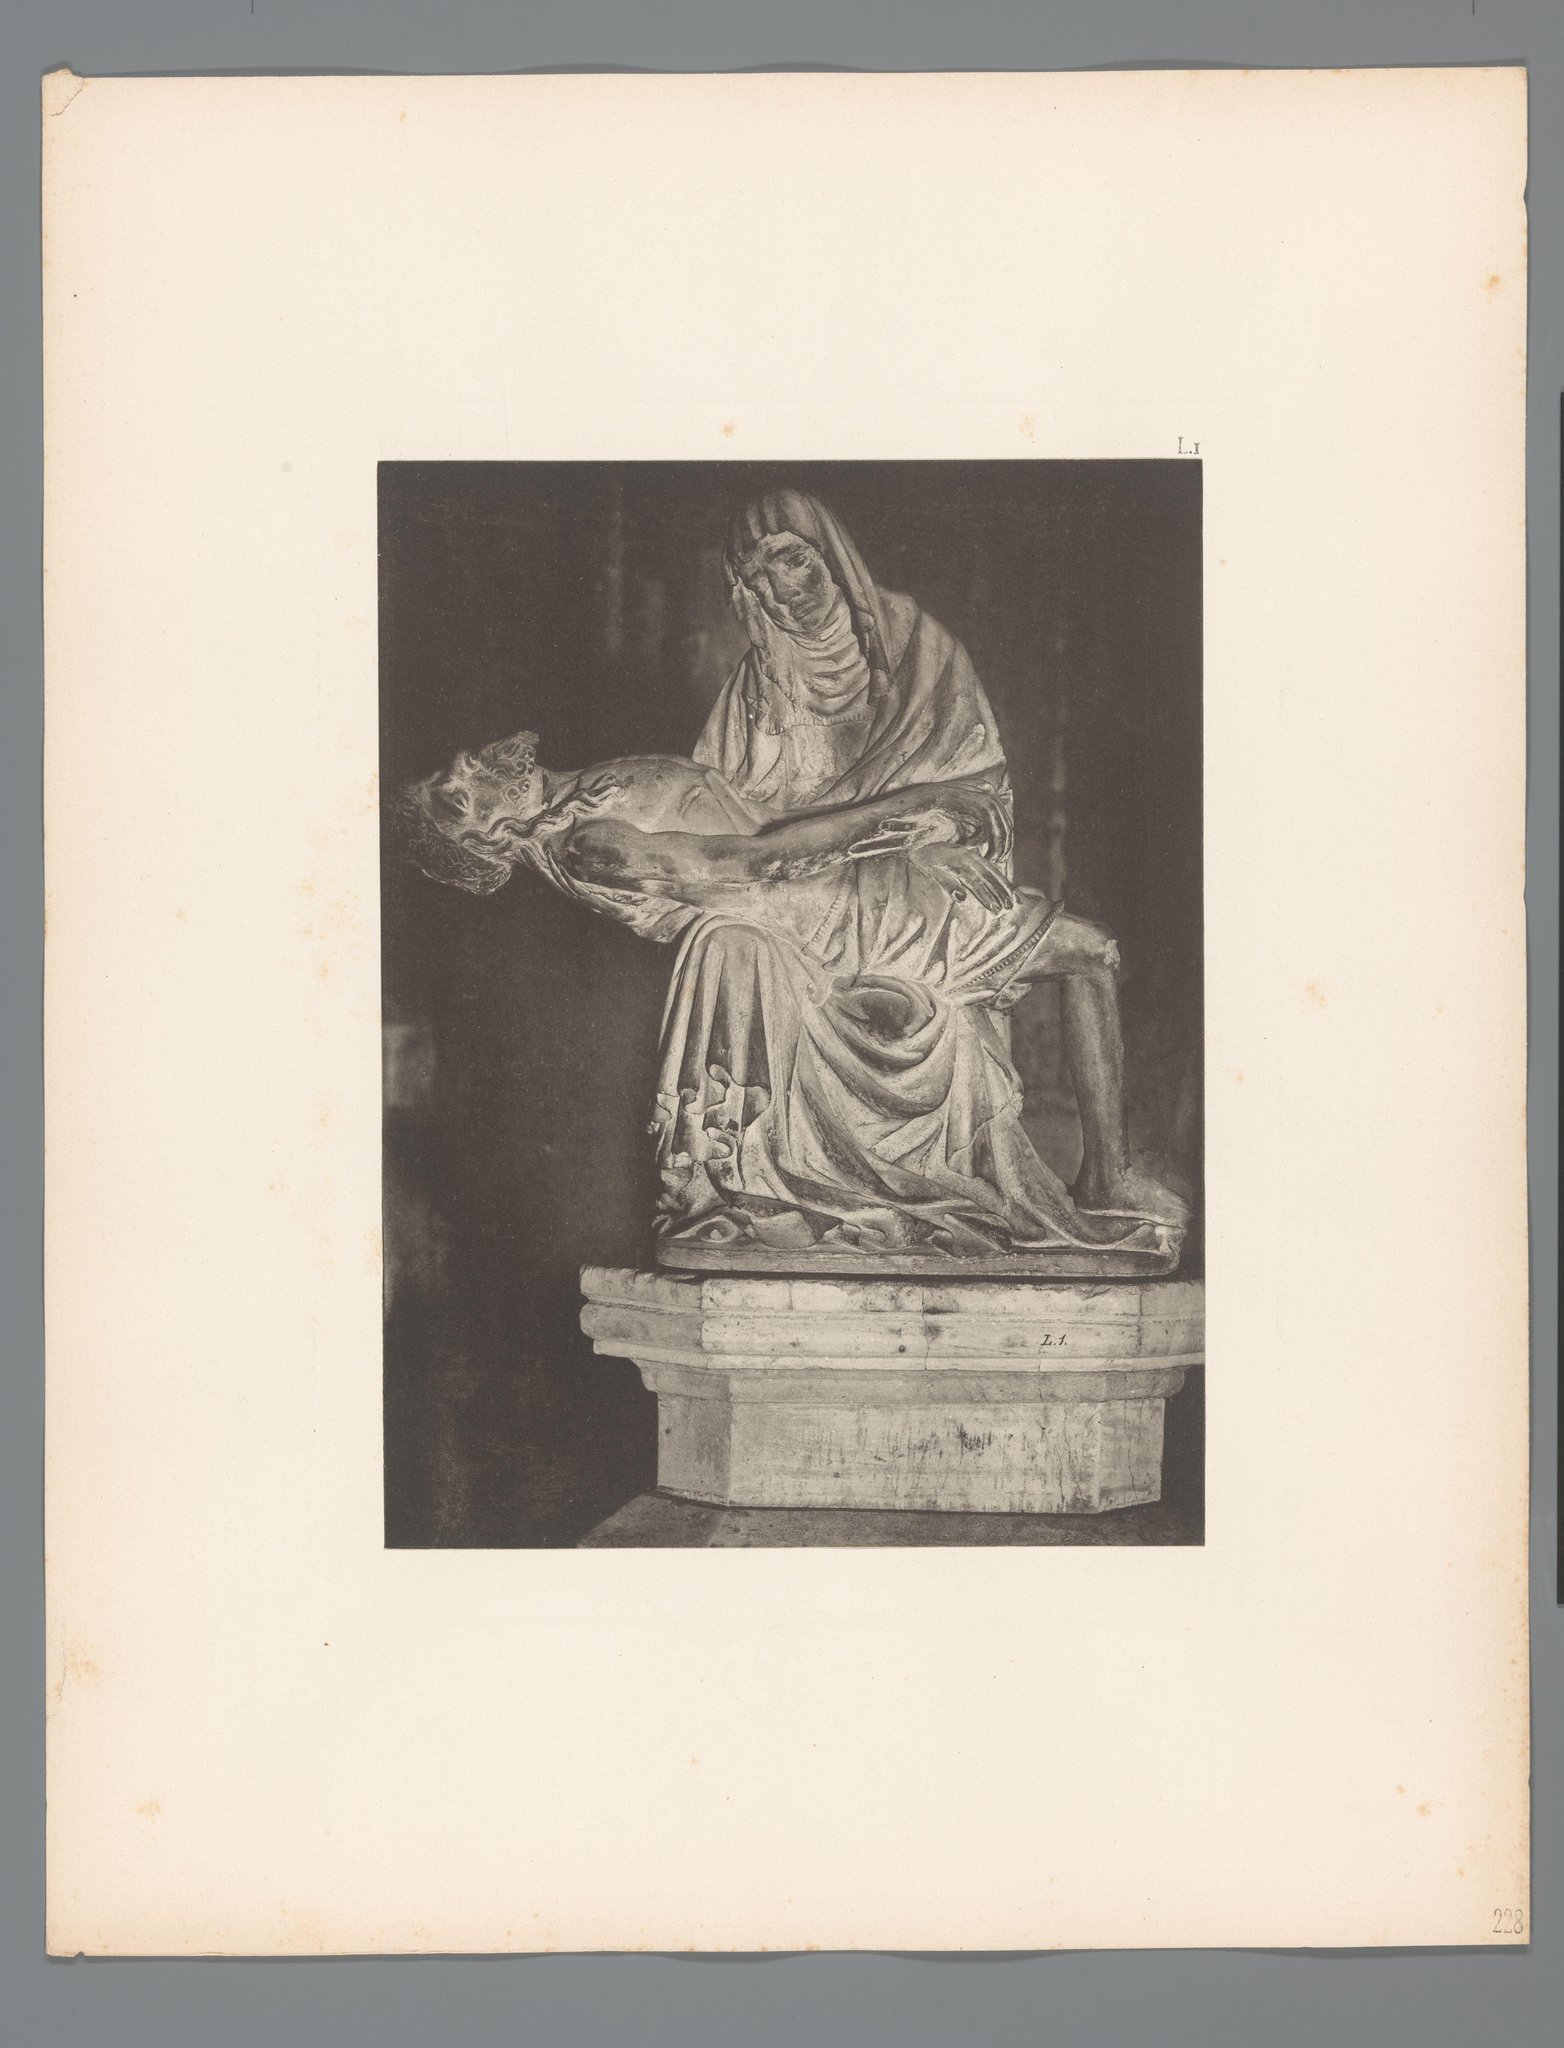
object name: photomechanical print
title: Piëta in de San Marco in Venetië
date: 1880-1885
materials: paper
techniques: photograph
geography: venice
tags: mary sitting or enthroned, the christ-child in front of her, lying in her lap (or in front of her bosom), sometimes in pietà-posture, piece of sculpture, reproduction of a piece of sculpture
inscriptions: number: ‘228’, number: ‘L.1.’, number: ‘L.I’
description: Deze prent maakt deel uit van een omslag met 79 prenten op 53 bladen en 2 tekstbladen.